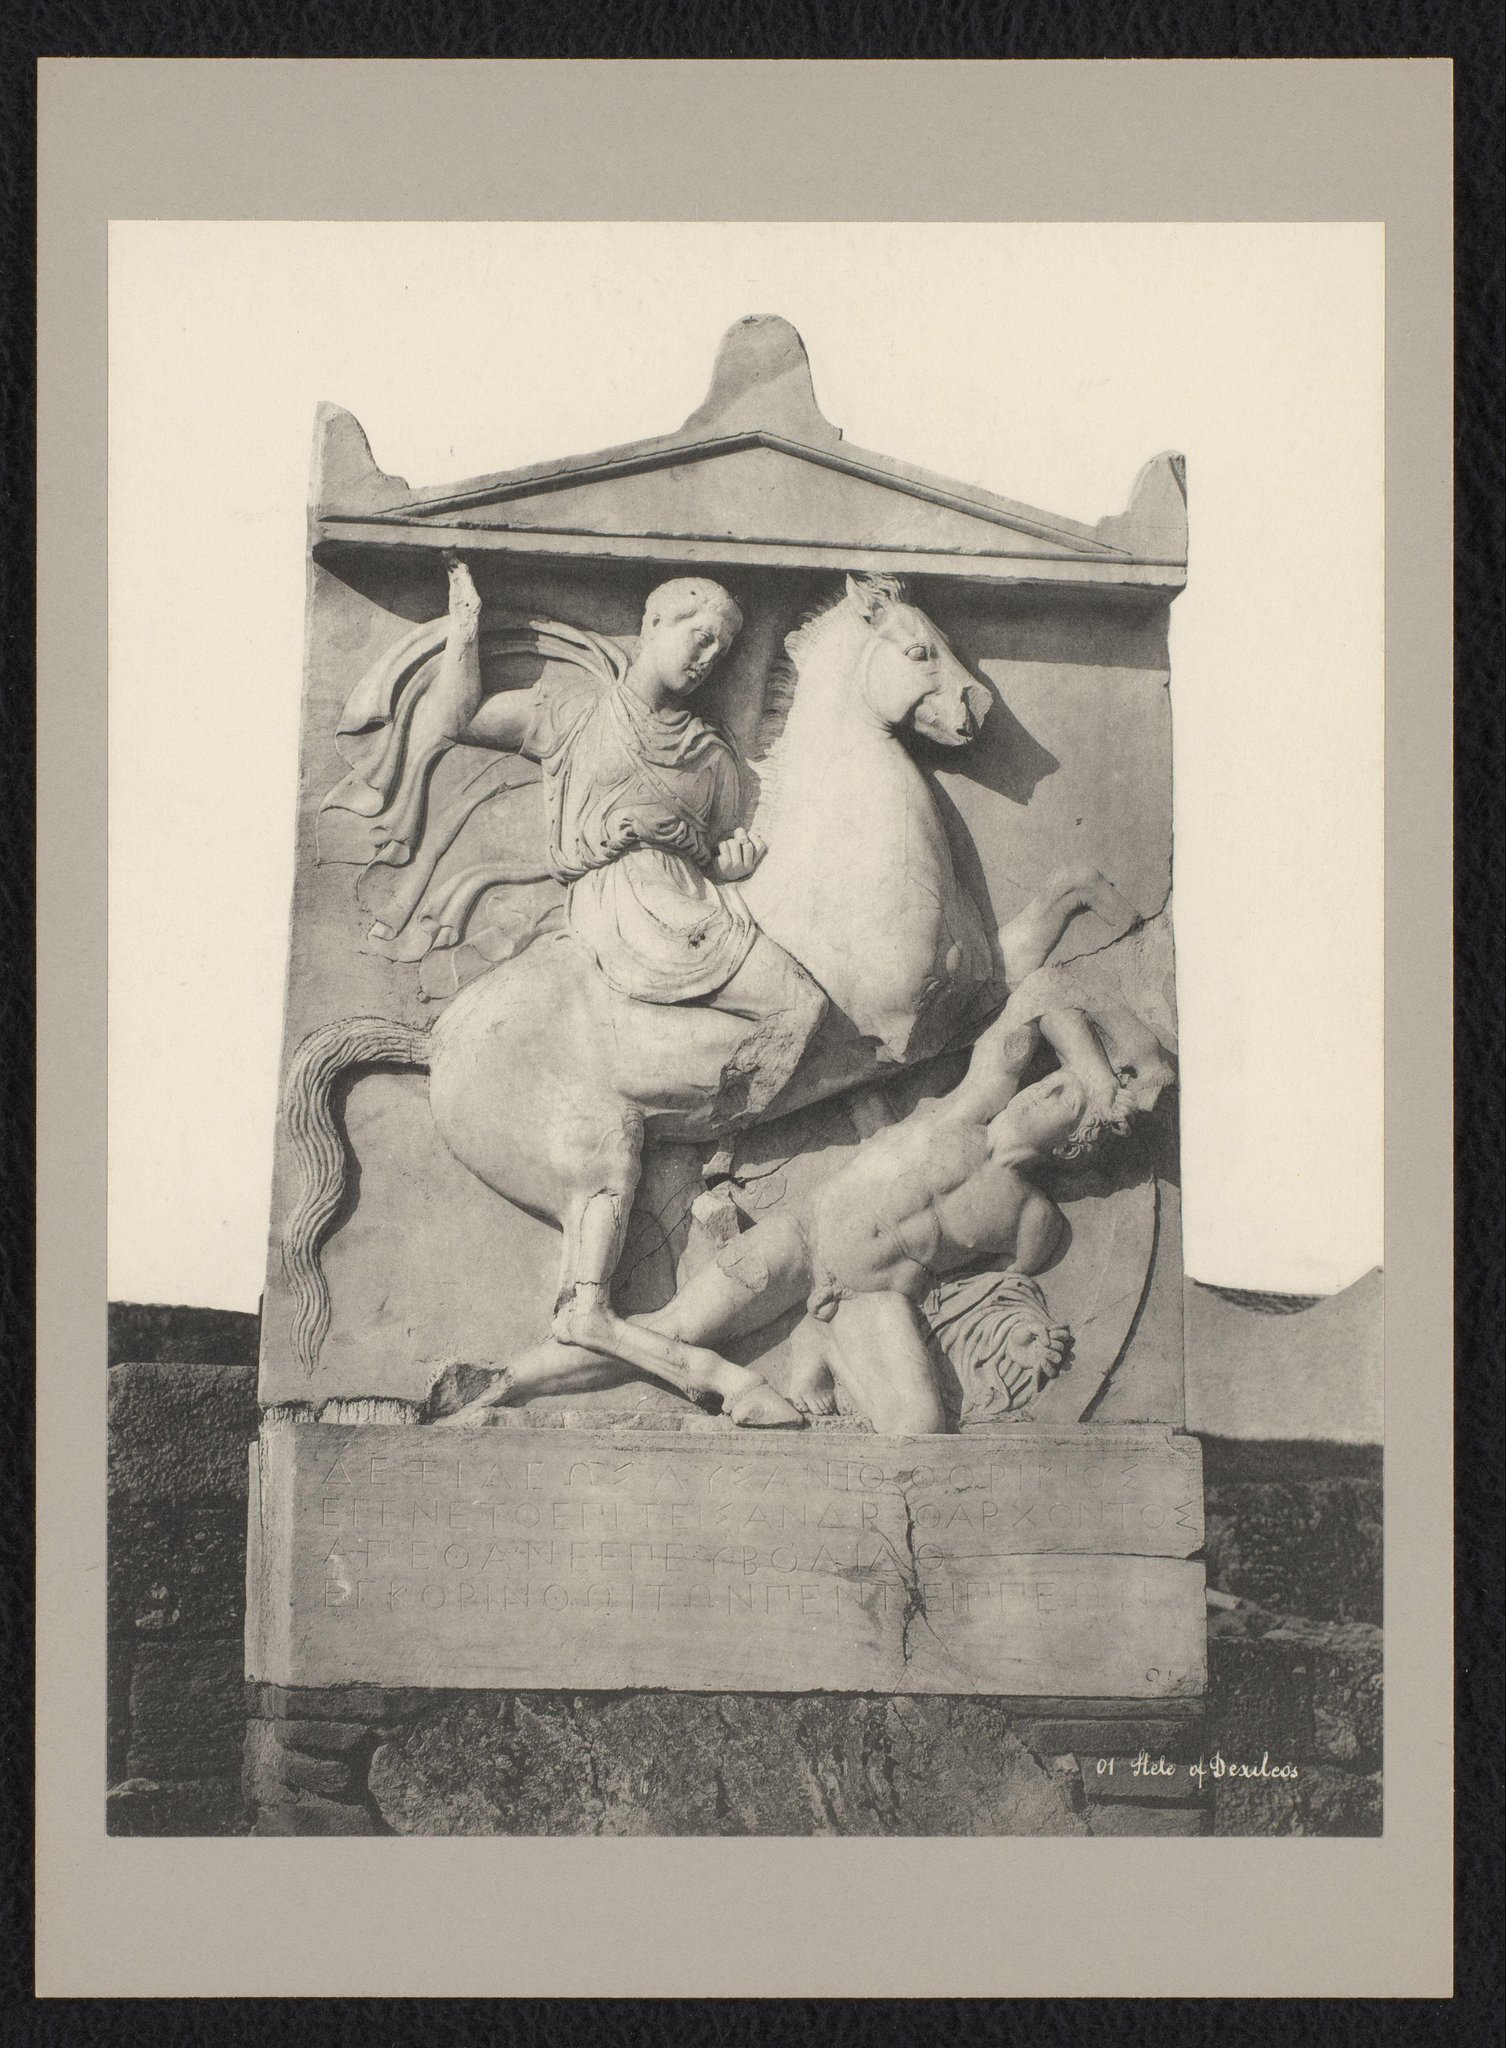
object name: photograph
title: Stèle van Dexileos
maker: Anonymous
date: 1895-1915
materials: cardboard, paper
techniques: photograph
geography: athens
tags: athene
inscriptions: number: ‘32.’